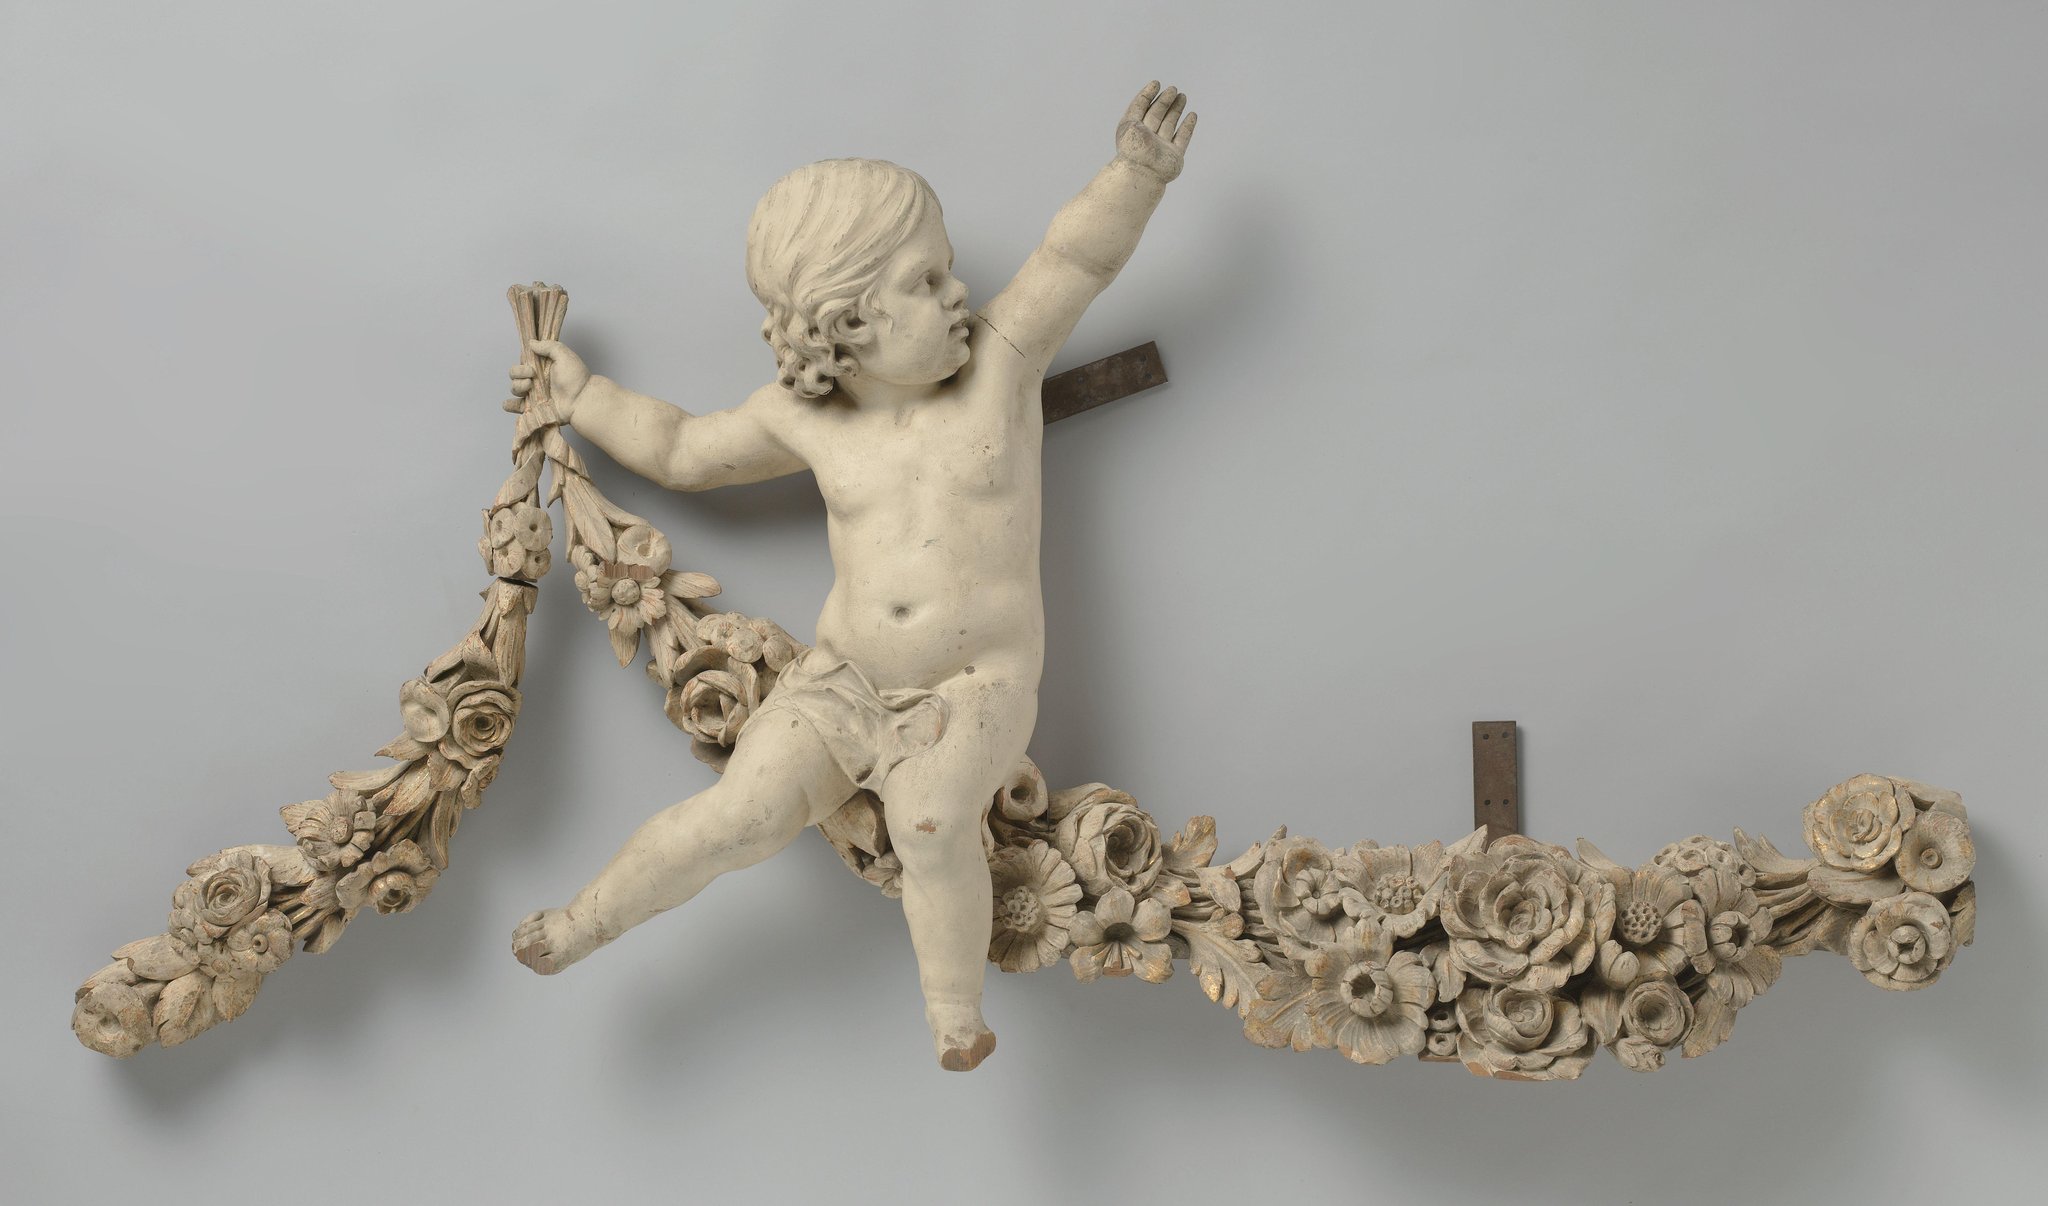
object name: sculpture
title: De vier elementen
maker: michiel emanuel shee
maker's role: sculptor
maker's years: -1740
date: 1730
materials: wood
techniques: cutting, painted